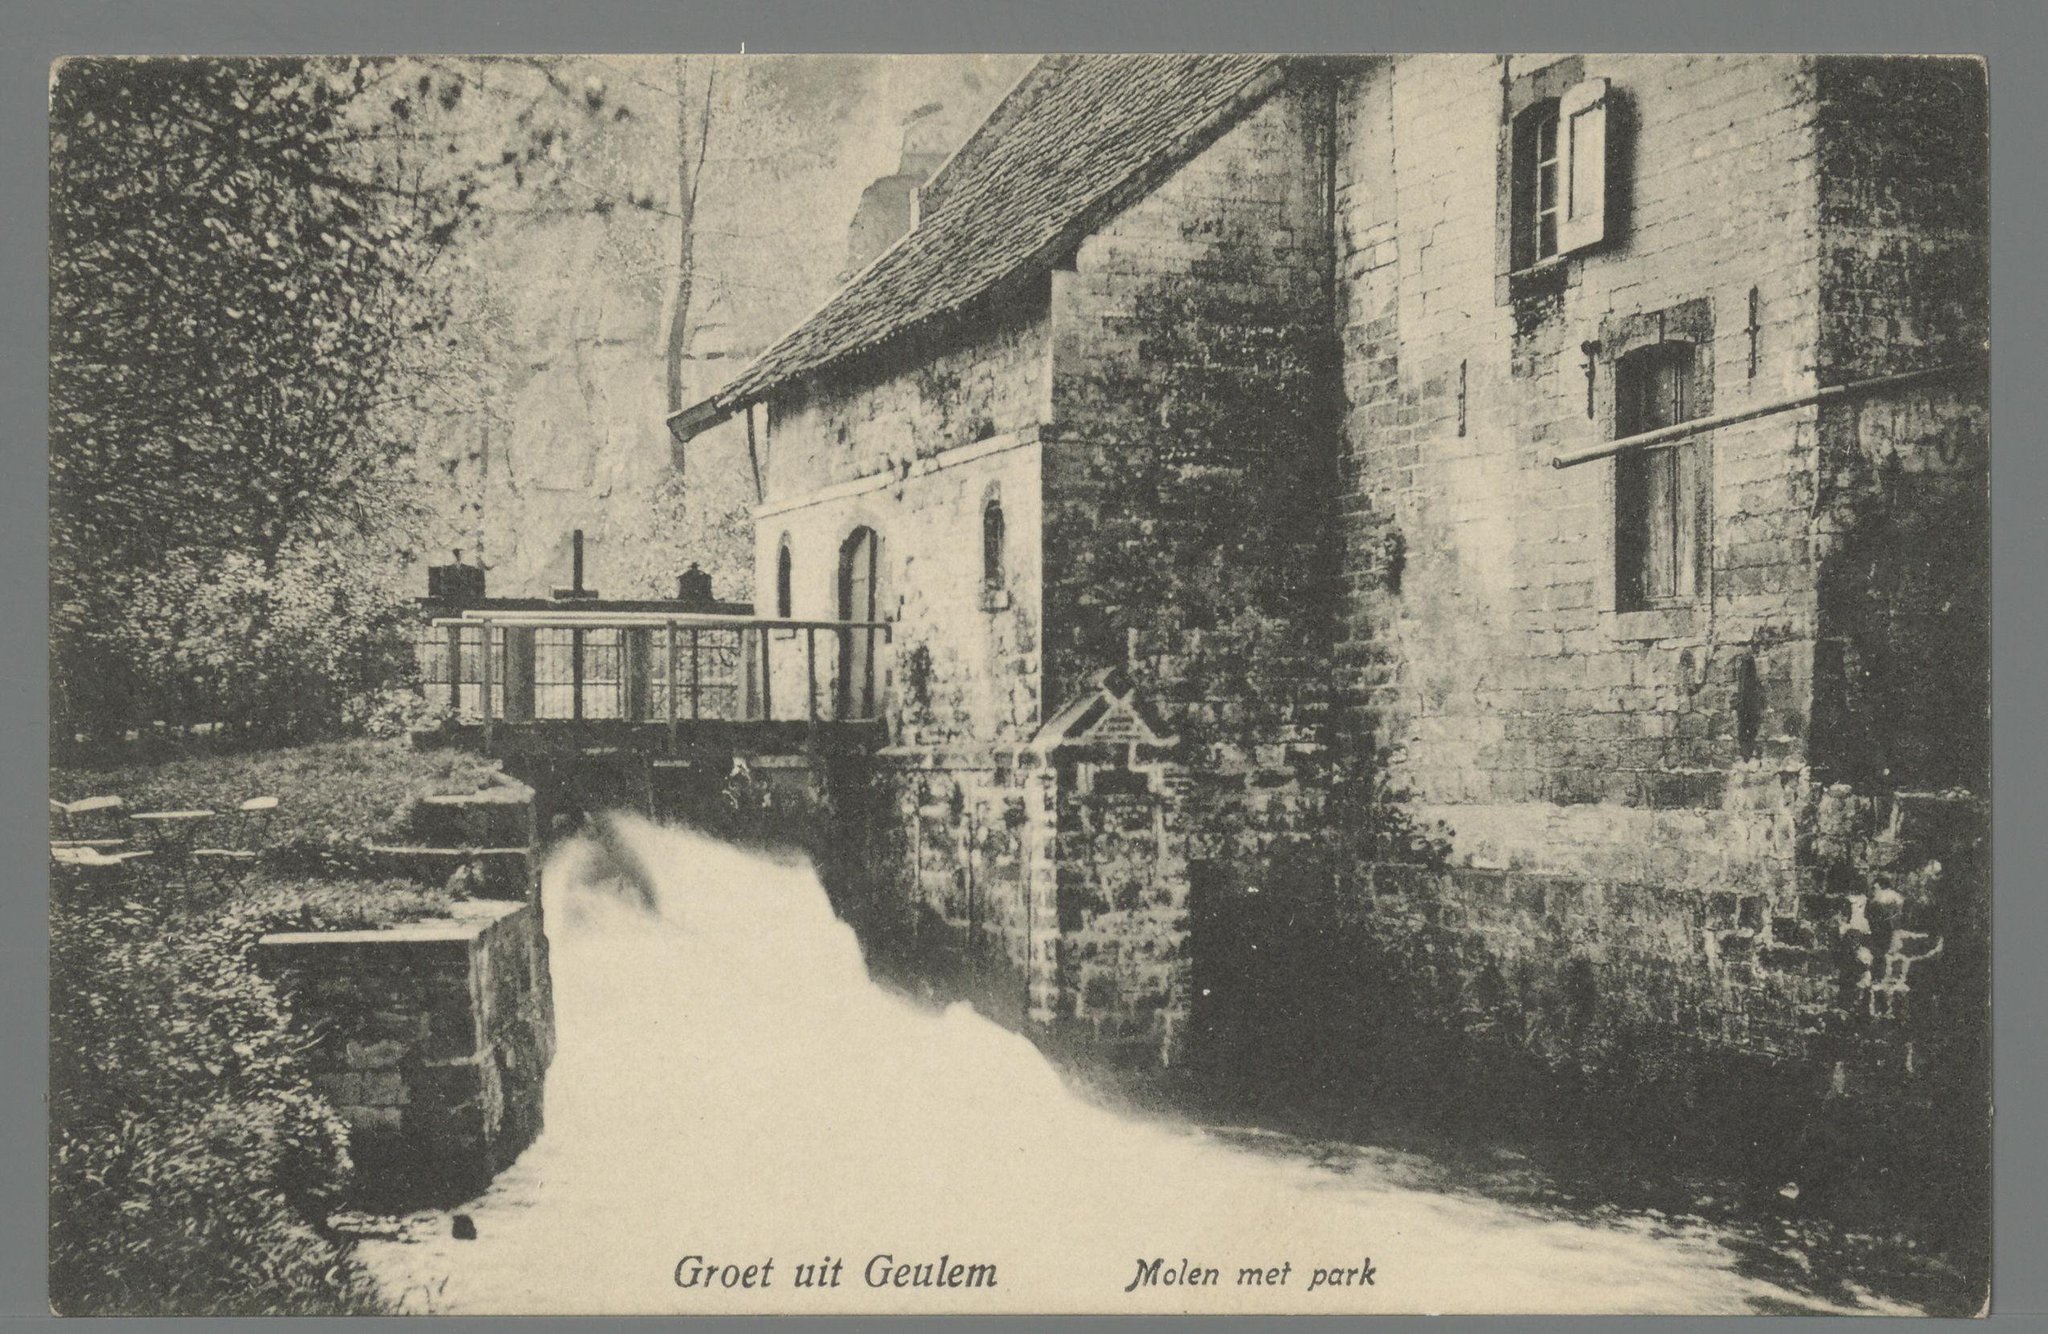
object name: ansichtkaart, prentbriefkaart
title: Groet uit Geulem. Molen met park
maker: Anonymous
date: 1905-1930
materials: cardboard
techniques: photograph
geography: geulhem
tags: canal, watermill, bridge